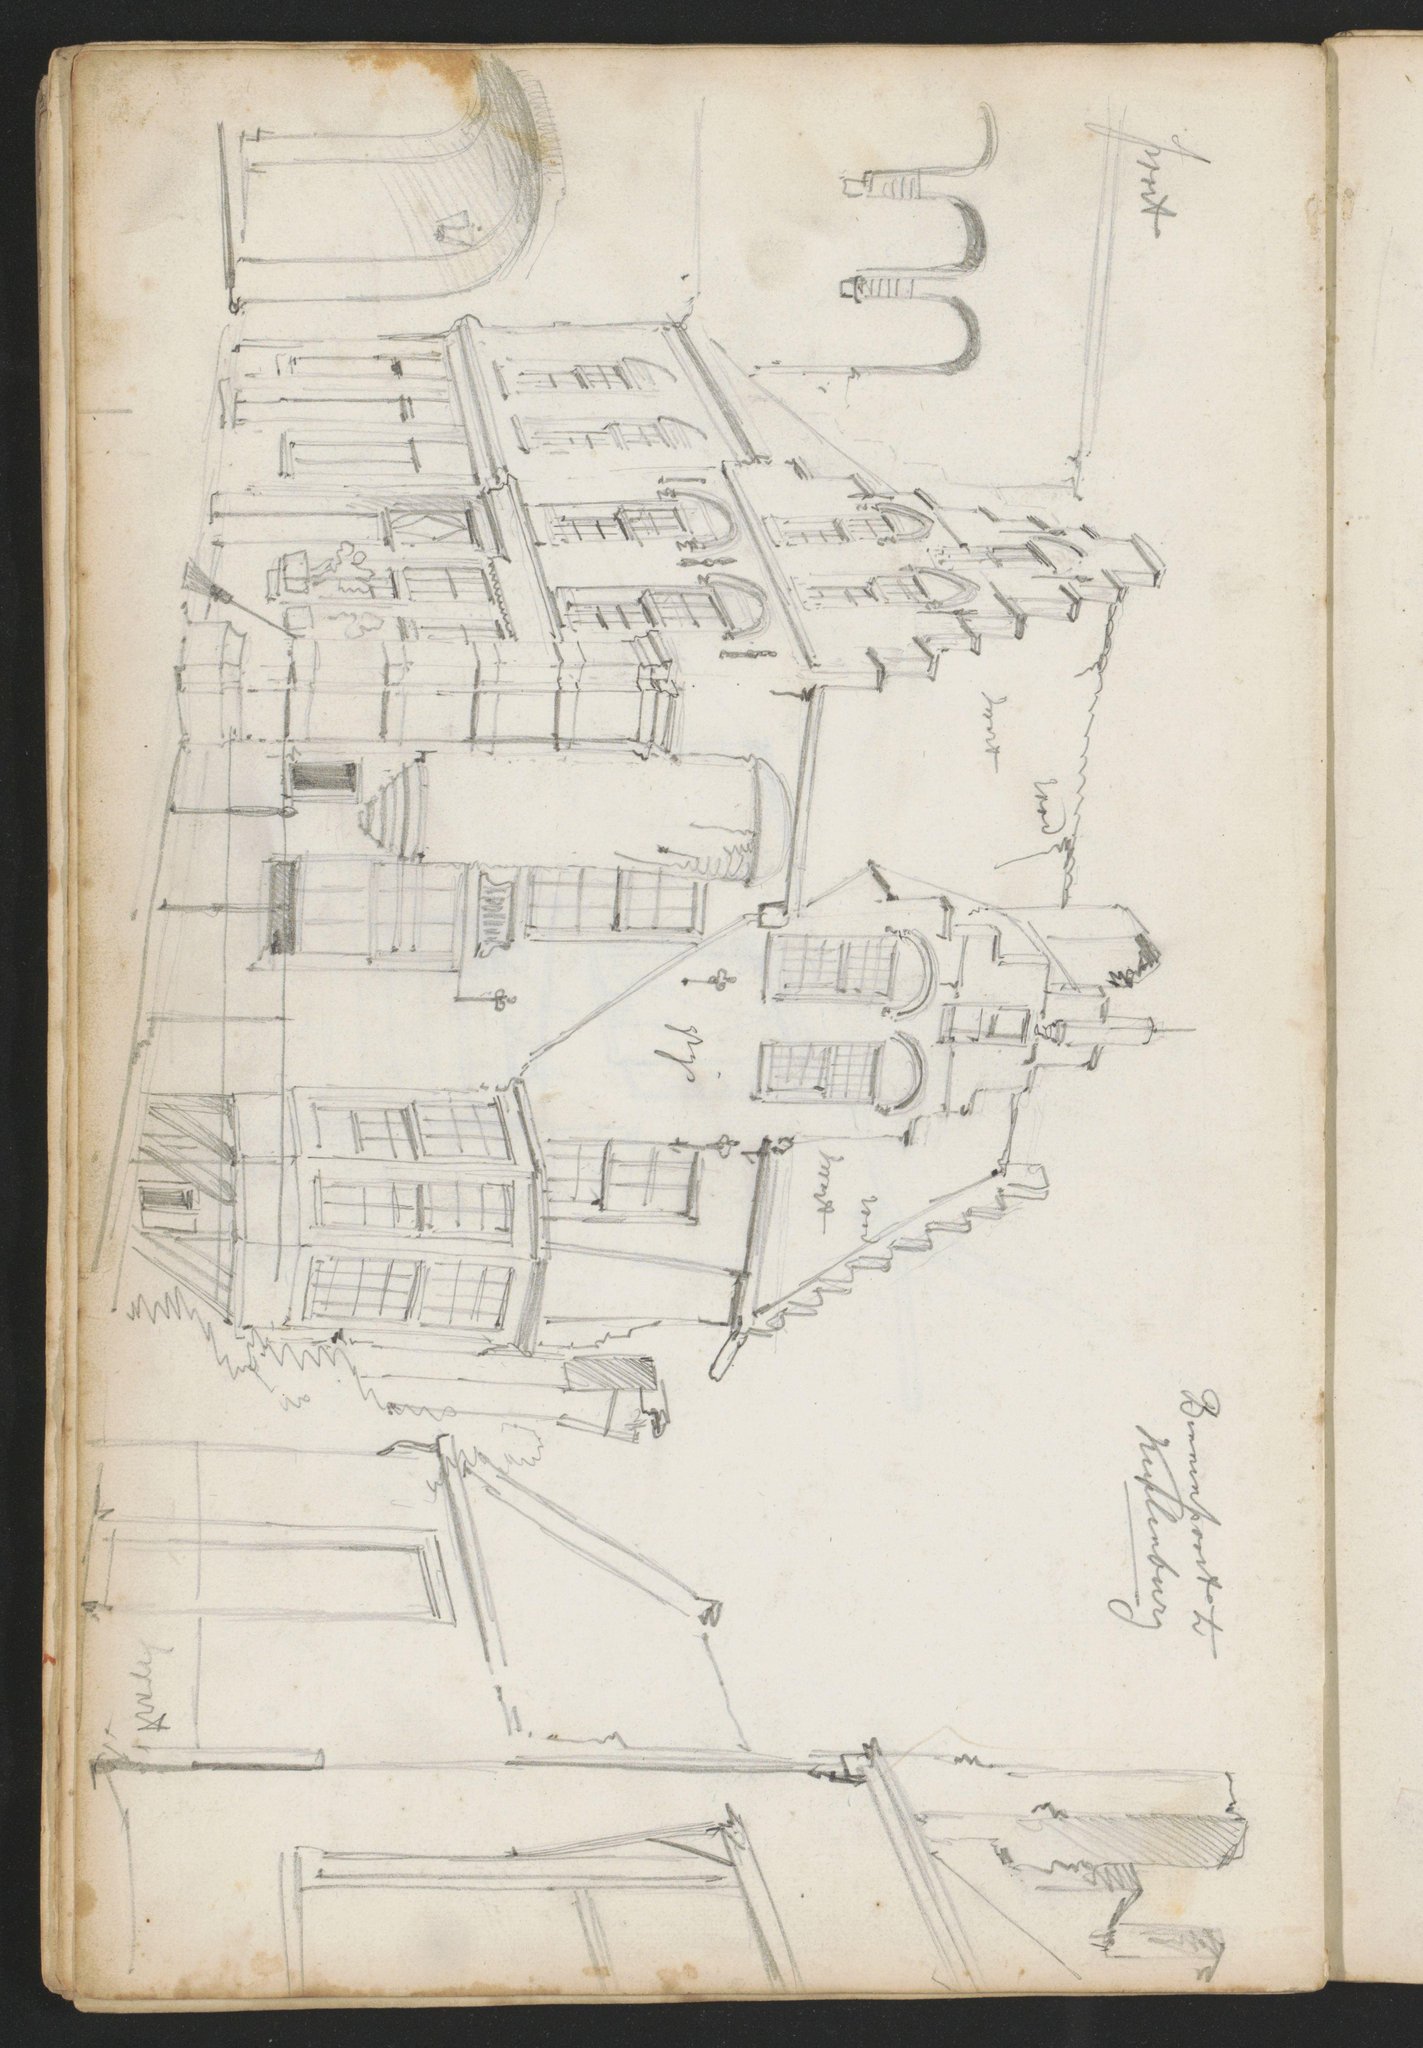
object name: sketchbook leaf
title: Binnenpoort te Culemborg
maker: willem koekkoek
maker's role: draughtsman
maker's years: 1839-1895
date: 1849-1895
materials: paper, pencil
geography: culemborg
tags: city-gate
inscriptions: annotation: ‘Binnenpoort te/ Kuilenburg/ poort’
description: Blad 25 verso uit een schetsboek met 42 bladen.